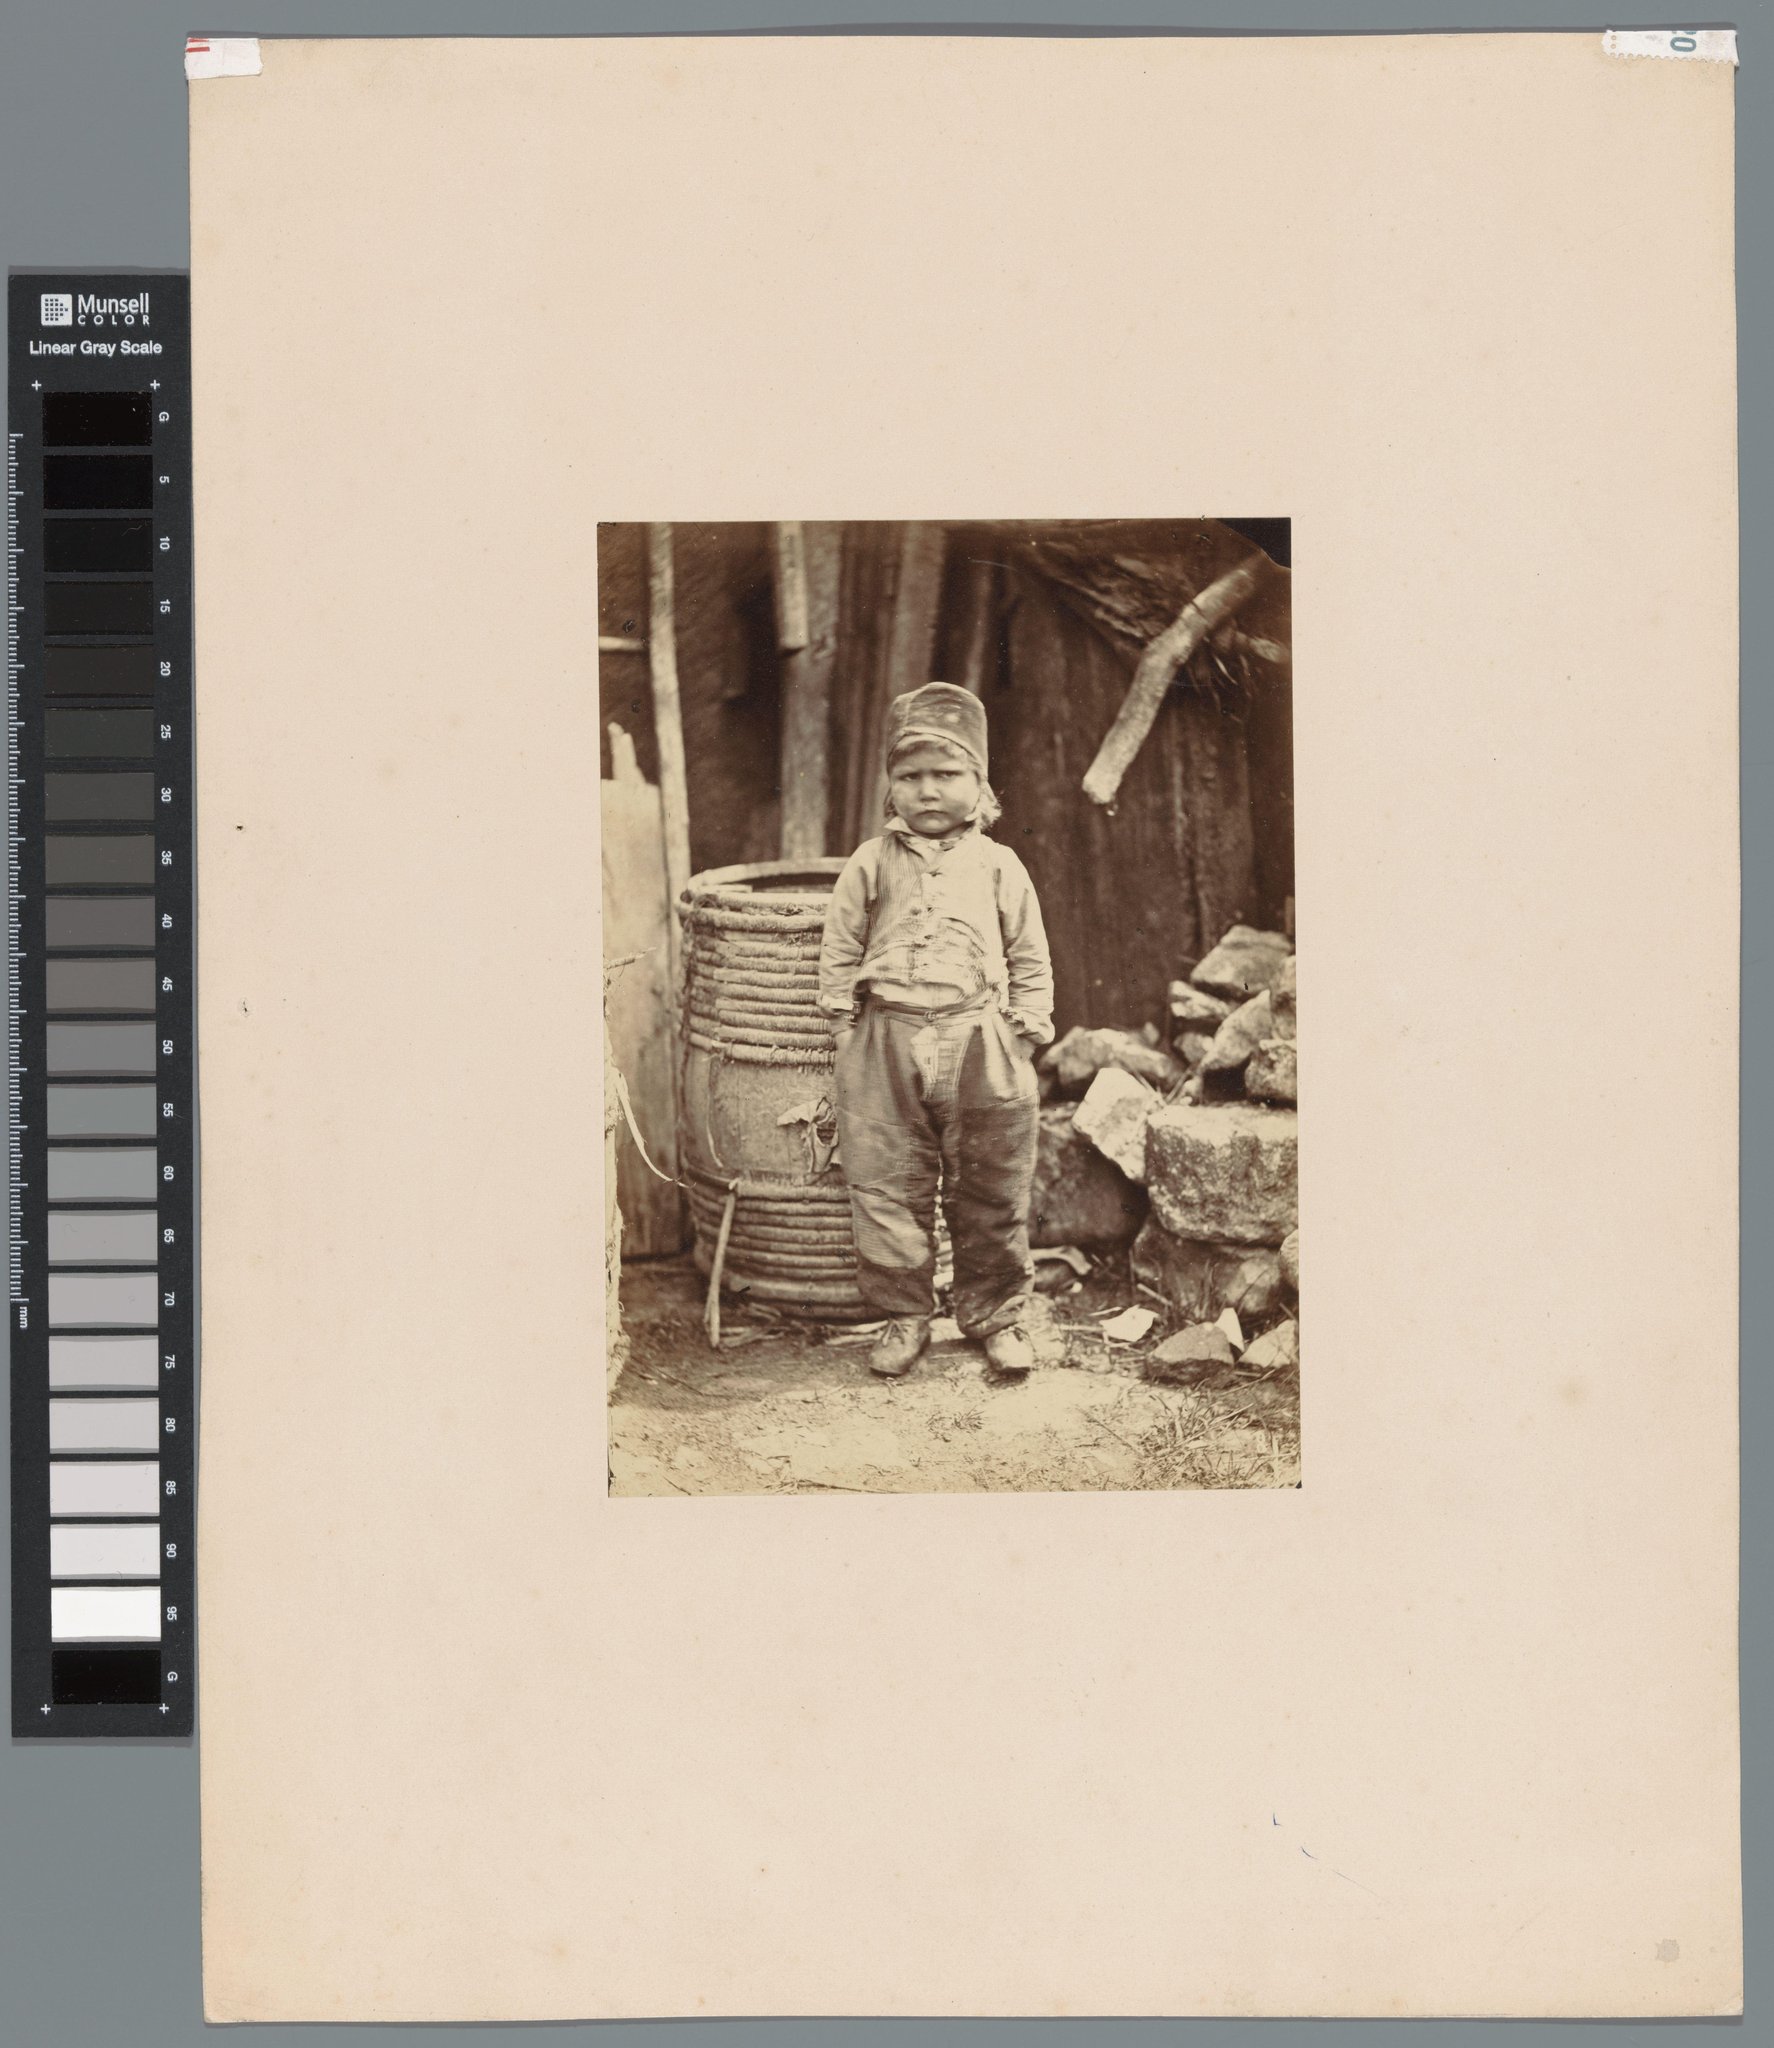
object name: photograph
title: Jeune garçon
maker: constant alexandre famin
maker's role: fotograaf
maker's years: 1827-1888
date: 1874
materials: paper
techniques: albumen print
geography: france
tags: boy (child between toddler and youth), historical persons not known by name, france